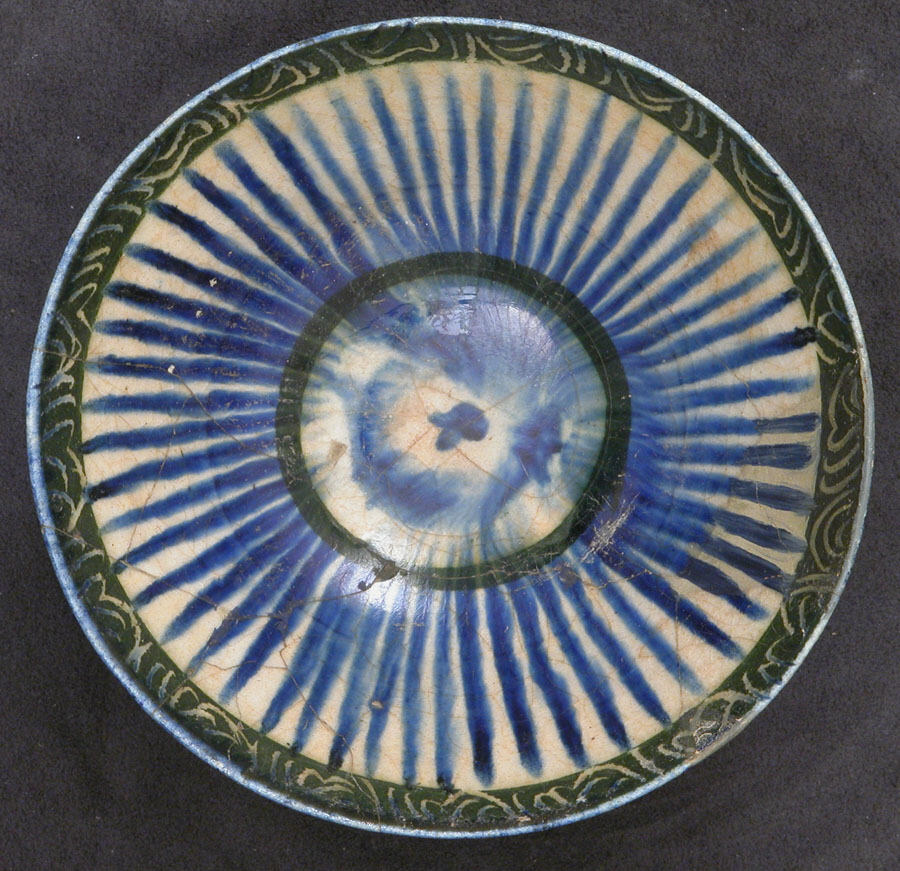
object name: bowl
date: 1201-1300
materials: stonepaste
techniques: painting, underglaze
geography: iran